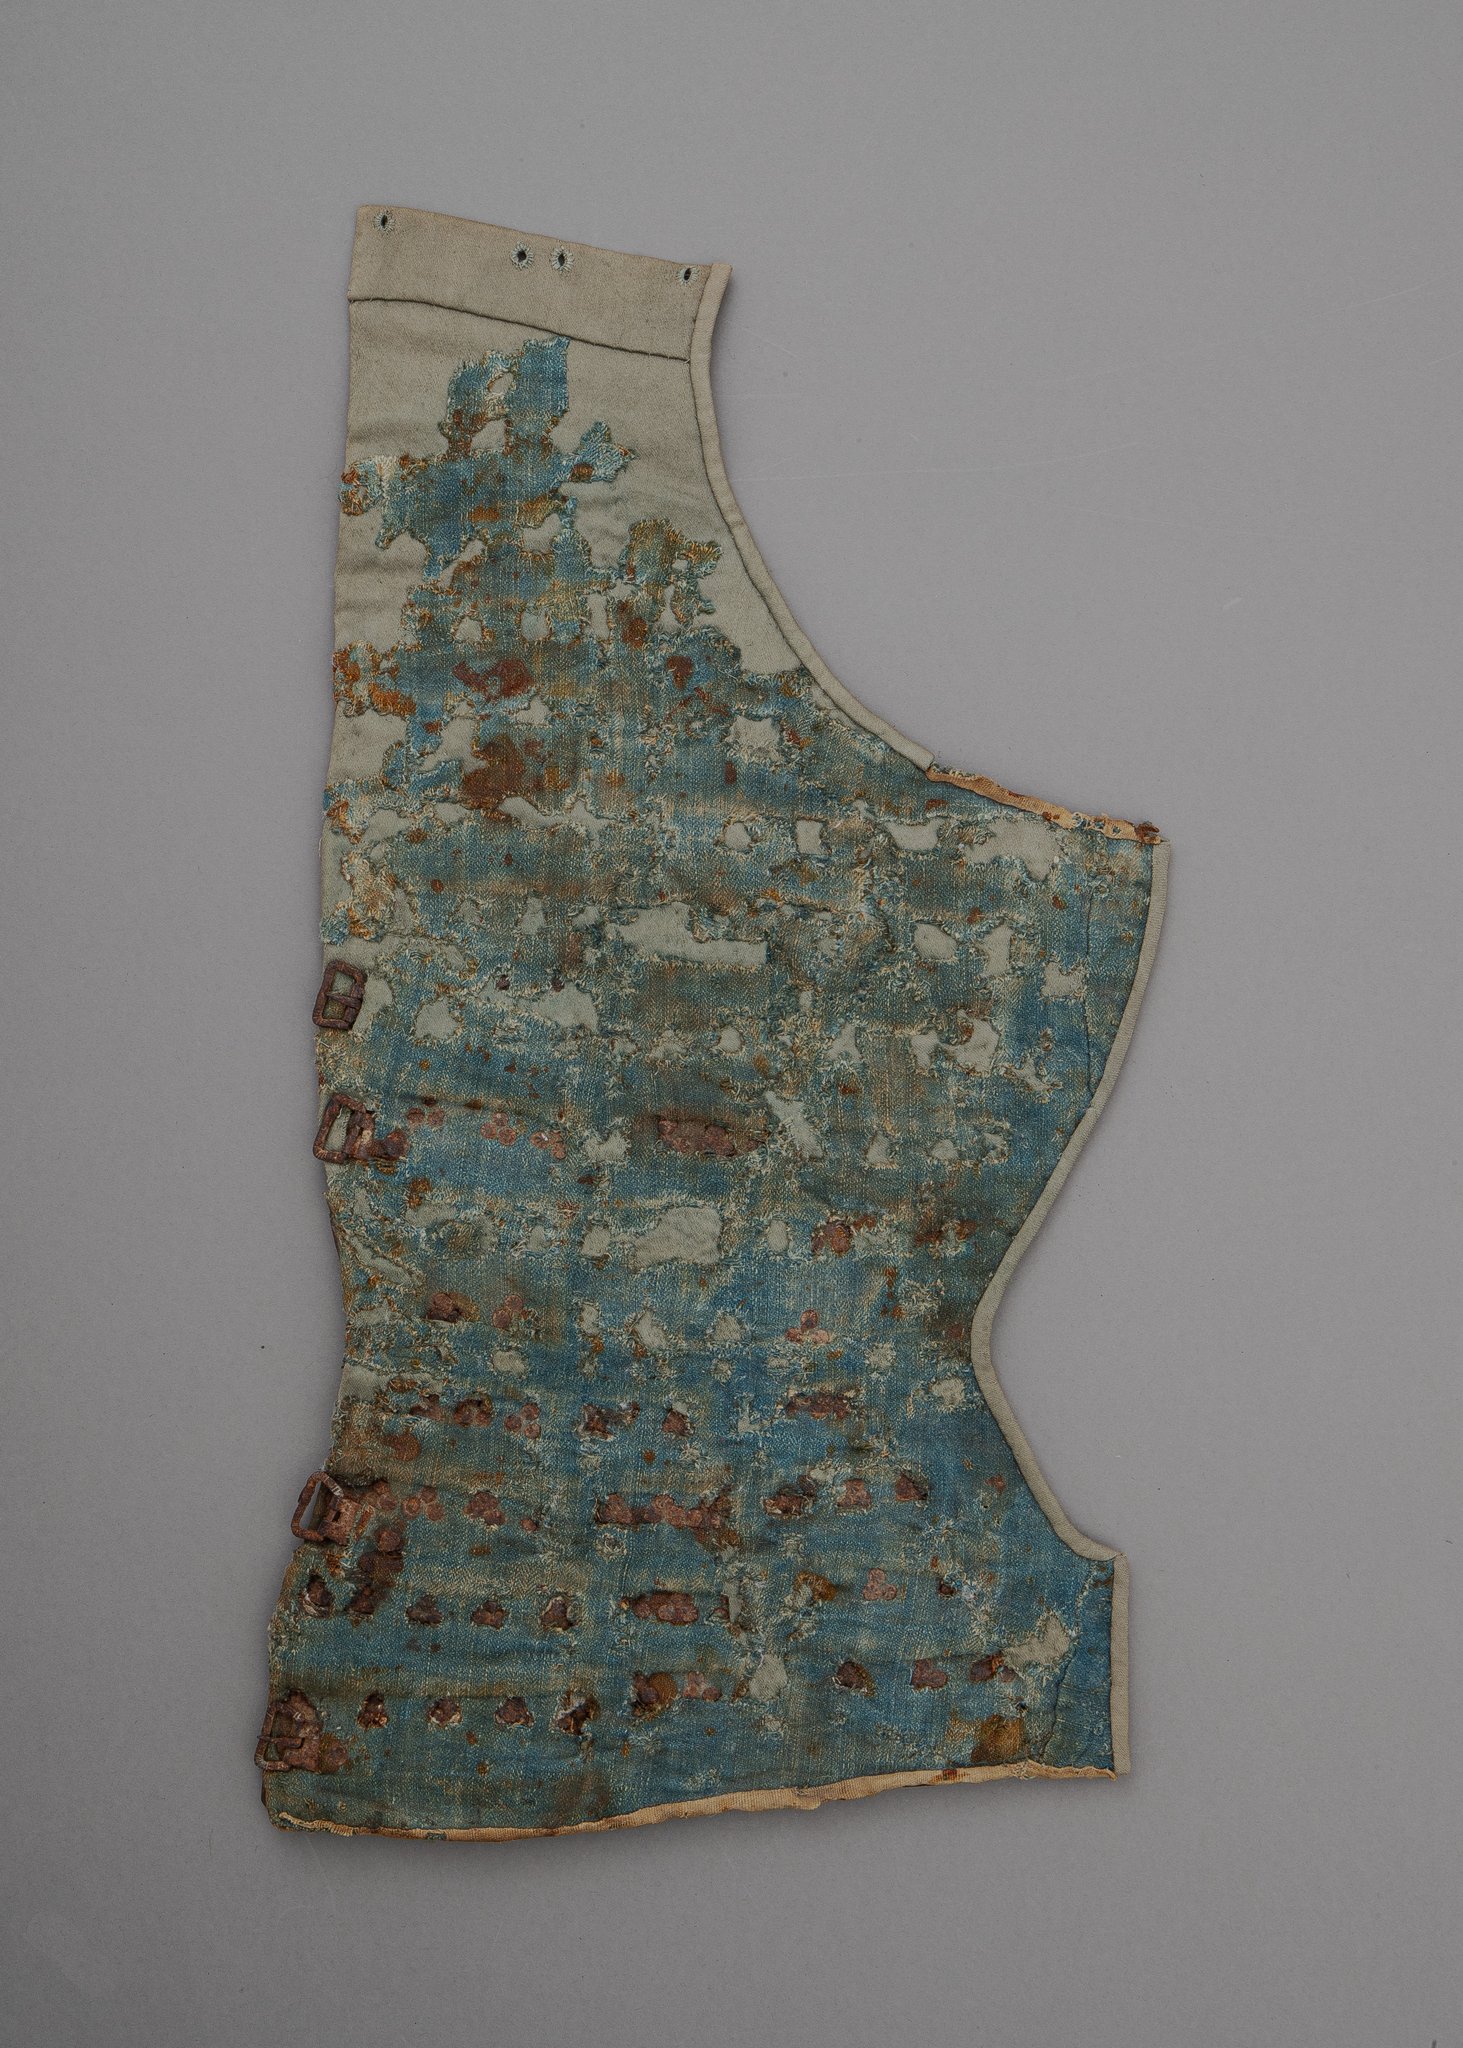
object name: brigandine, fragment of front left half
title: Fragment of the Left Half of the Front of a Brigandine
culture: italian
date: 1460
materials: iron, textile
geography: greece